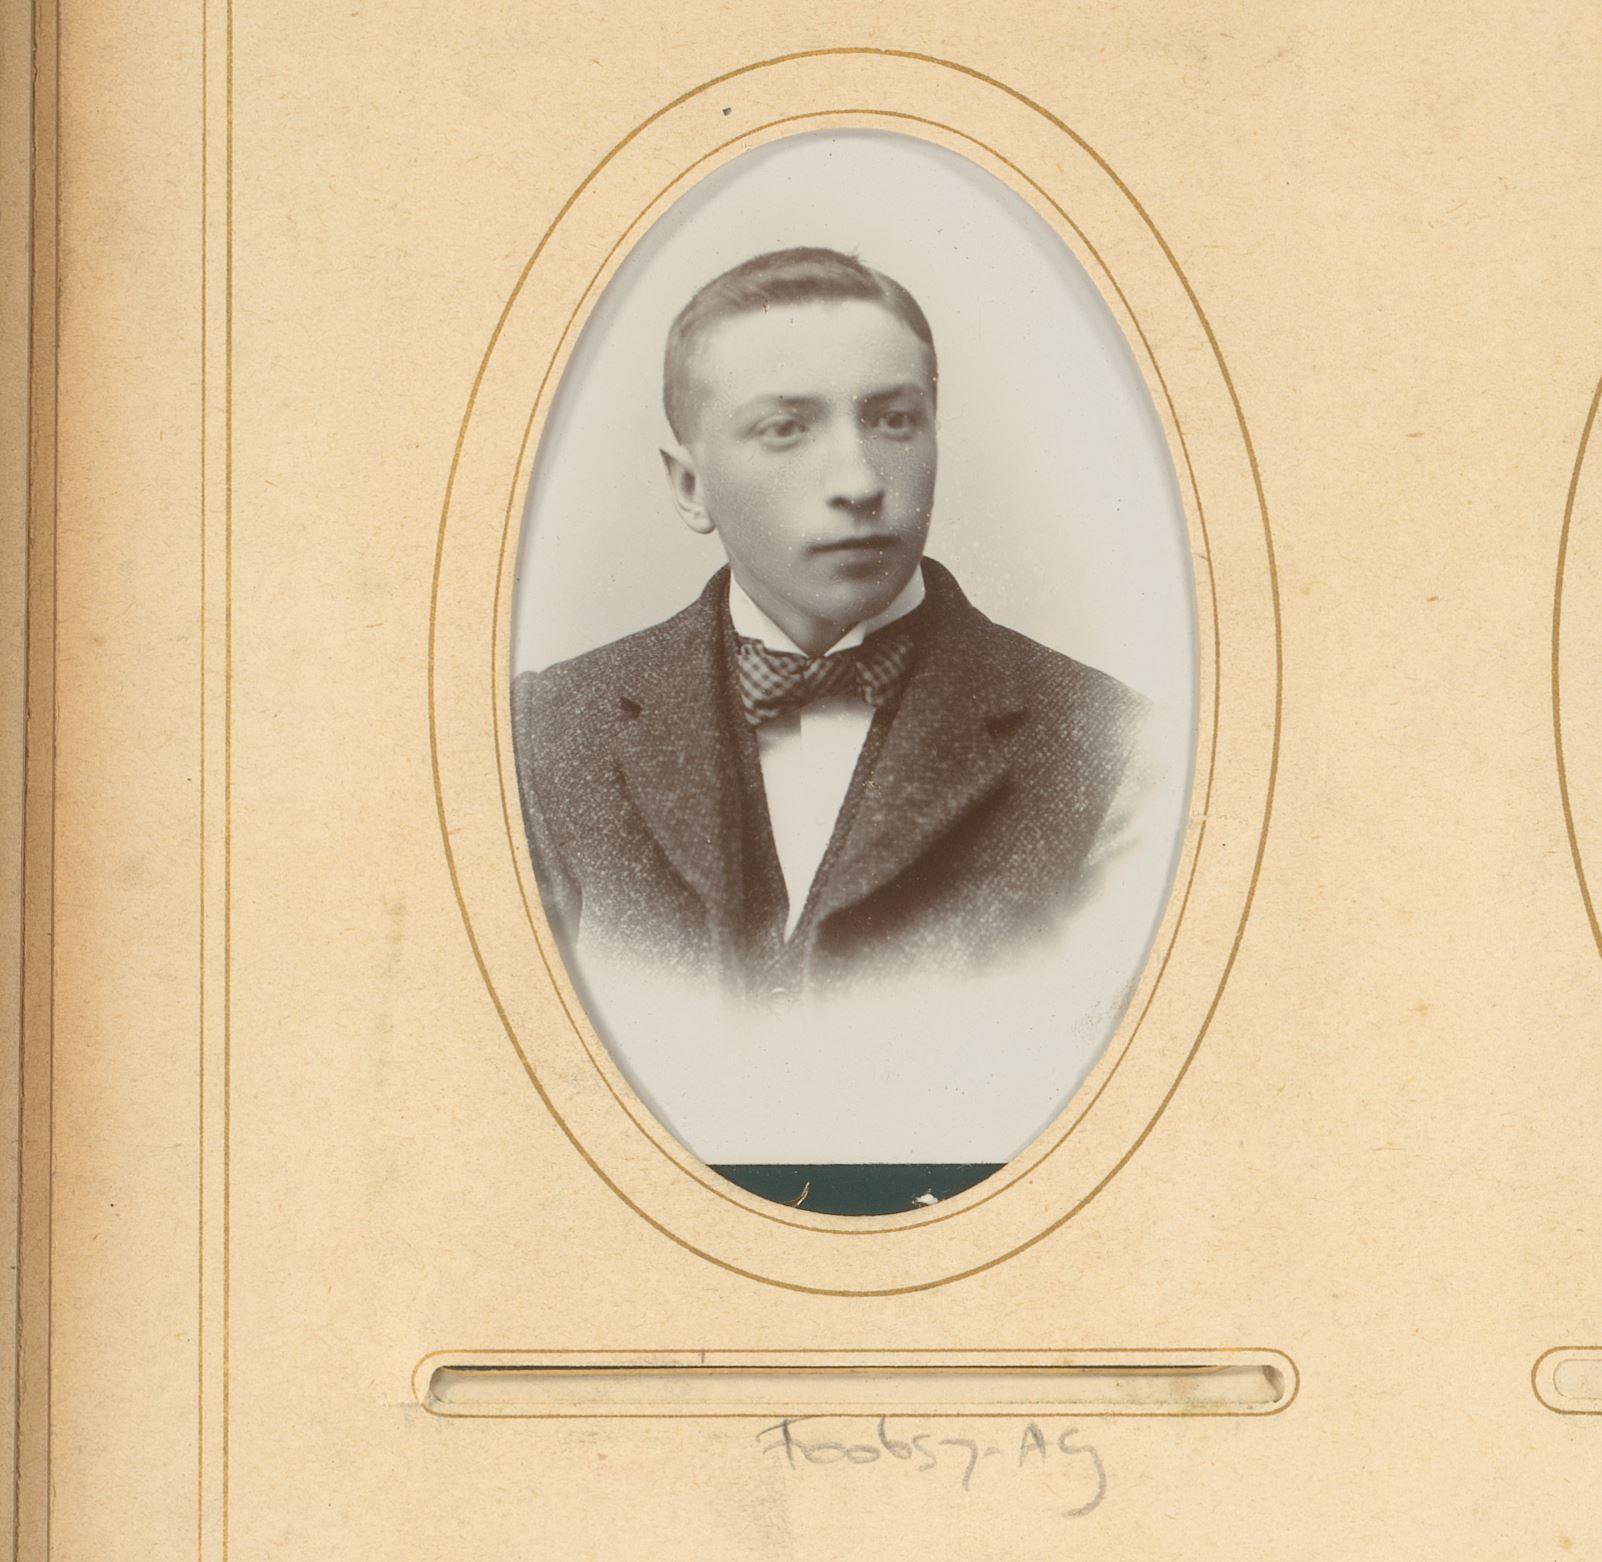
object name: album leaf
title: Portret van en jonge man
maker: alfred wragg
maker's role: fotograaf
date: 1882-1940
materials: cardboard, photographic support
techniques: gelatin silver print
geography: ormskirk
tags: historical persons, youth, adolescent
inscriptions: inscription: ‘Alfred Wragg/ Burscough St/ Ormskirk’